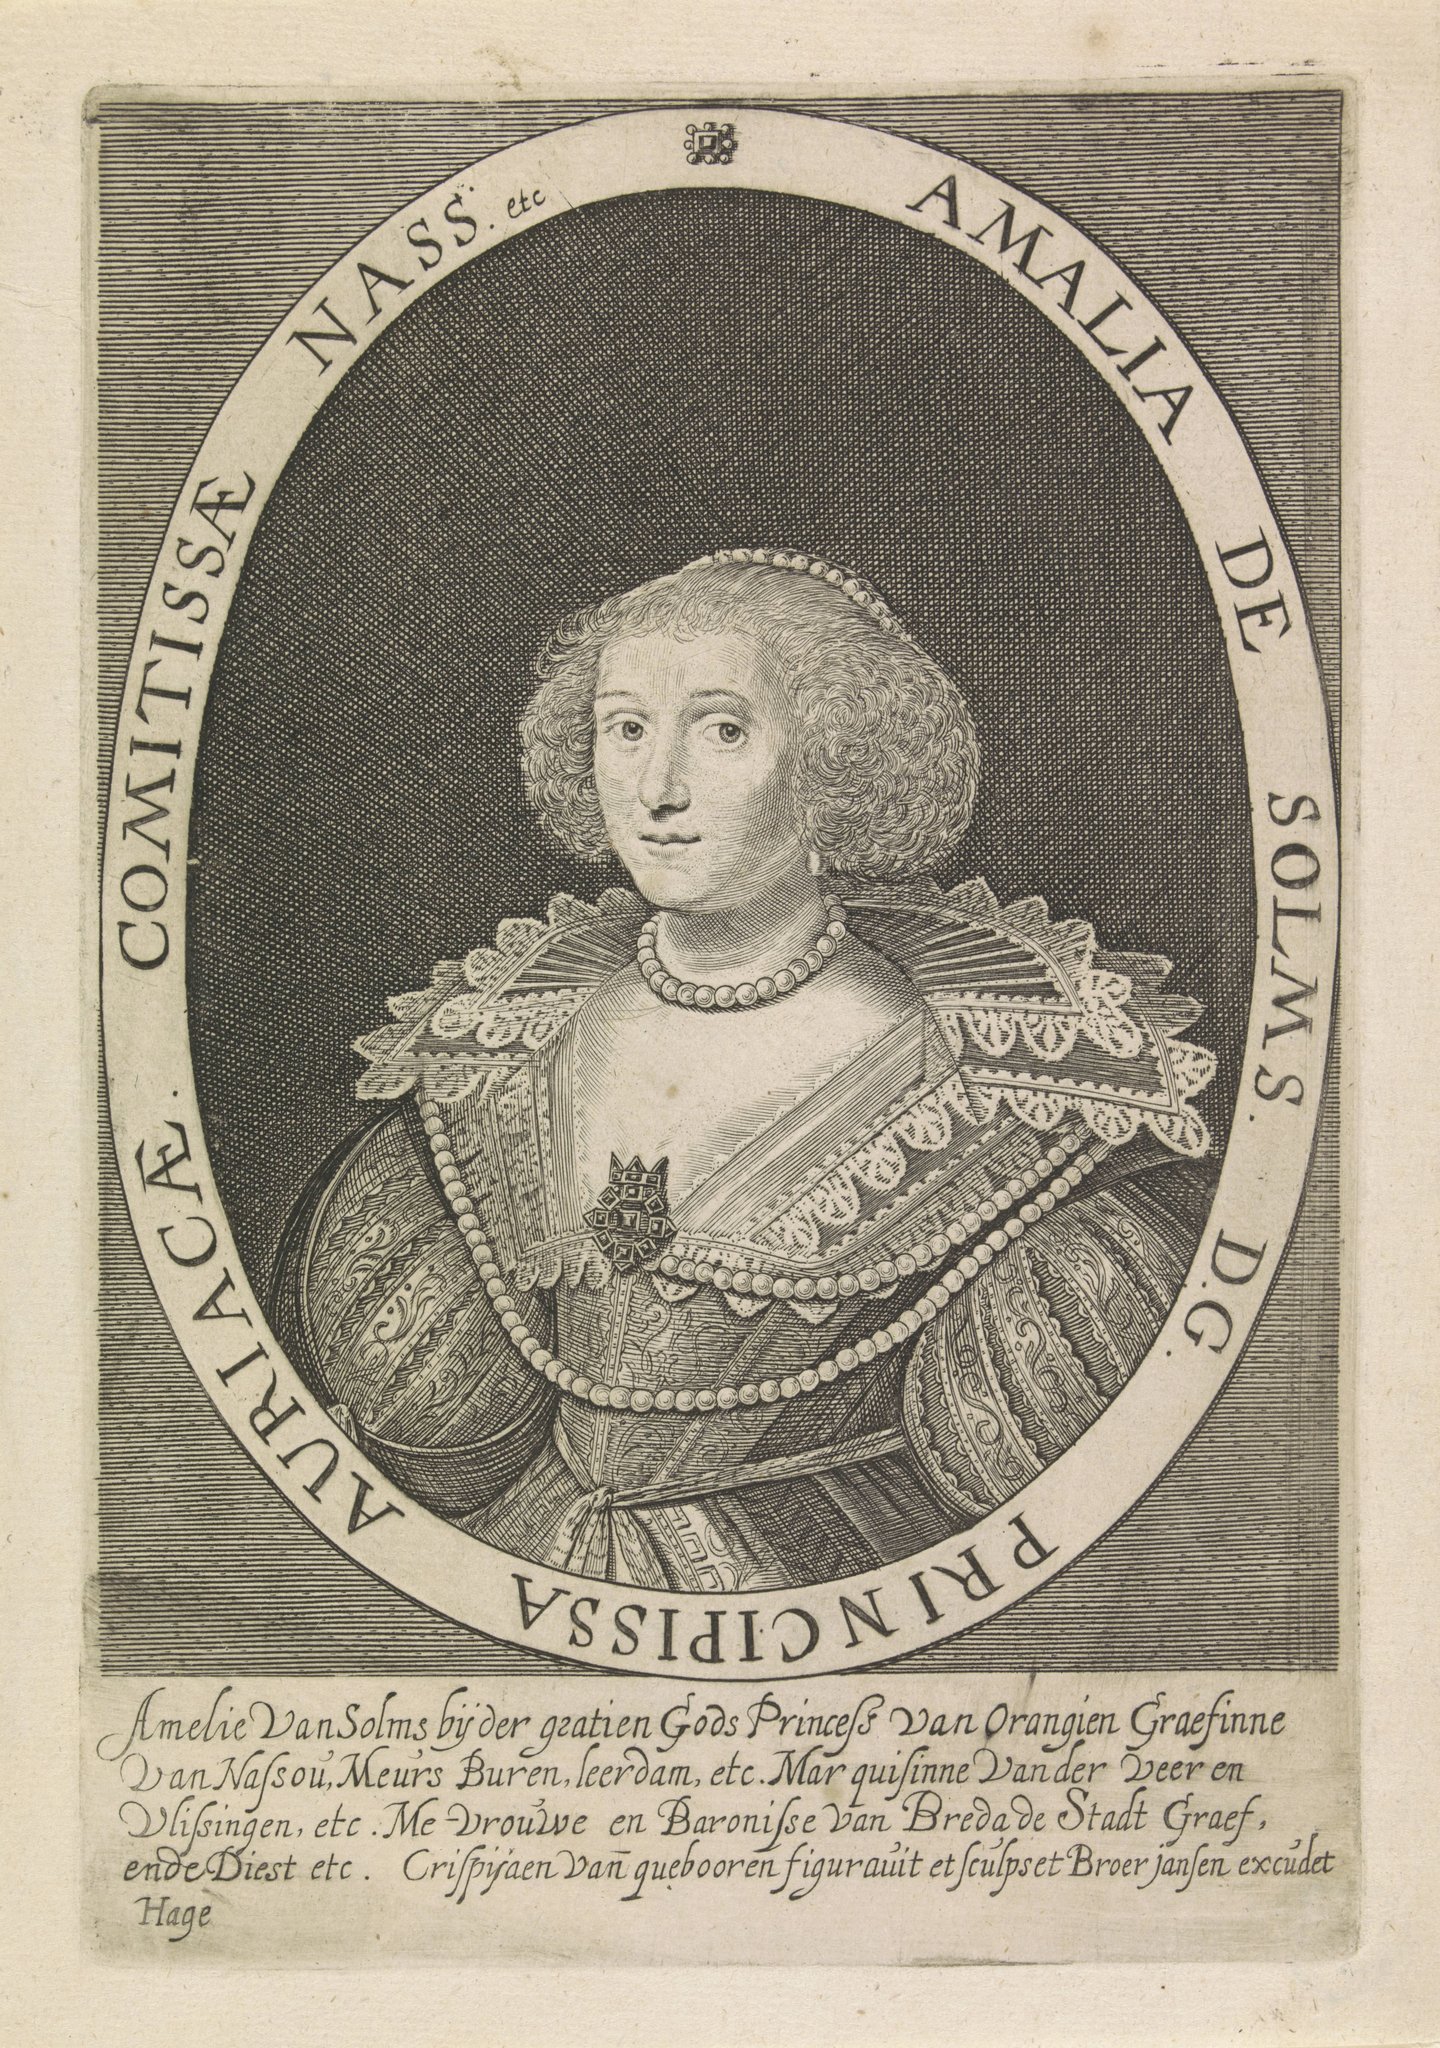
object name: print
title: Portret van Amalia van Solms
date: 1620-1629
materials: paper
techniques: engraving, etching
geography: the hague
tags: amalia of solms-braunfels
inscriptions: collector's mark: Lugt 963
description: Portret van Amalia in een ovaal met randschrift. In de ondermarge vier regels Nederlandse tekst.